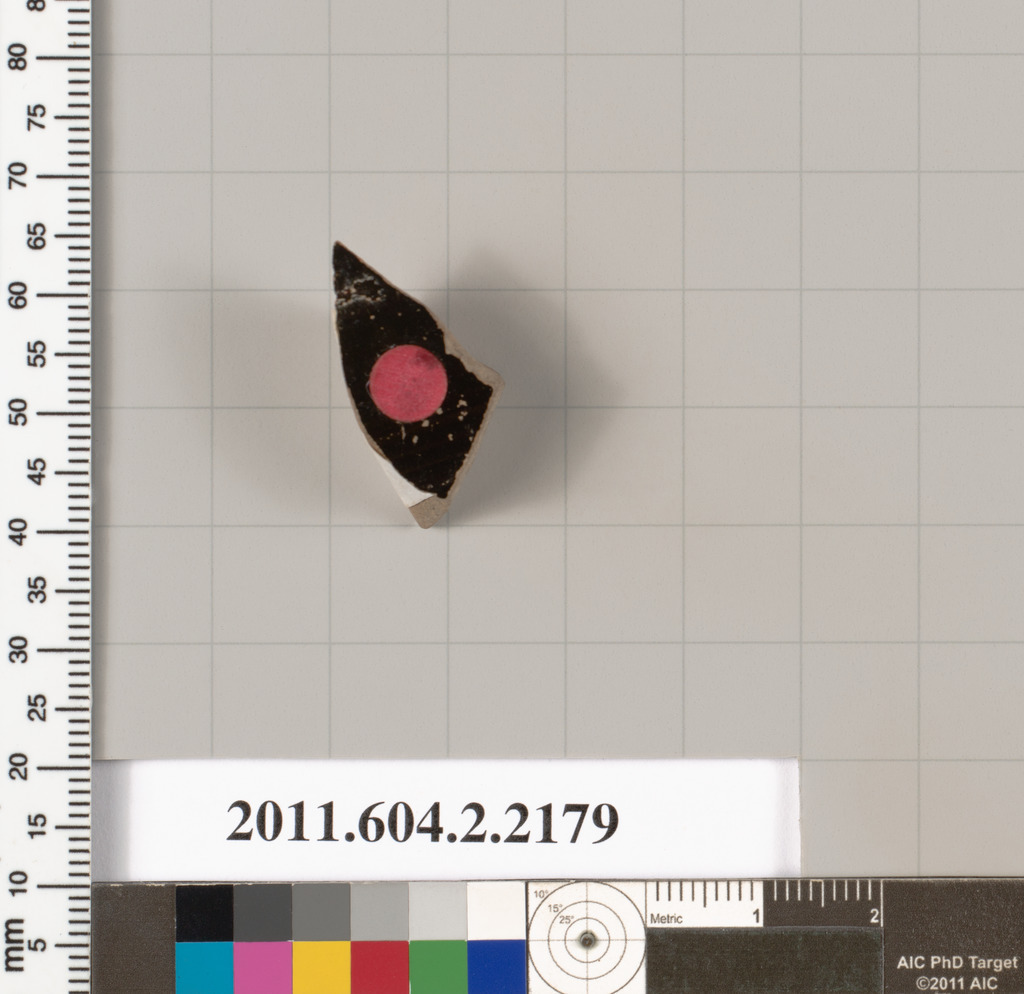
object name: pot fragment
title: Terracotta fragment of a pot; unglazed on the inside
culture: greek, attic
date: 600-401 BCE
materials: terracotta